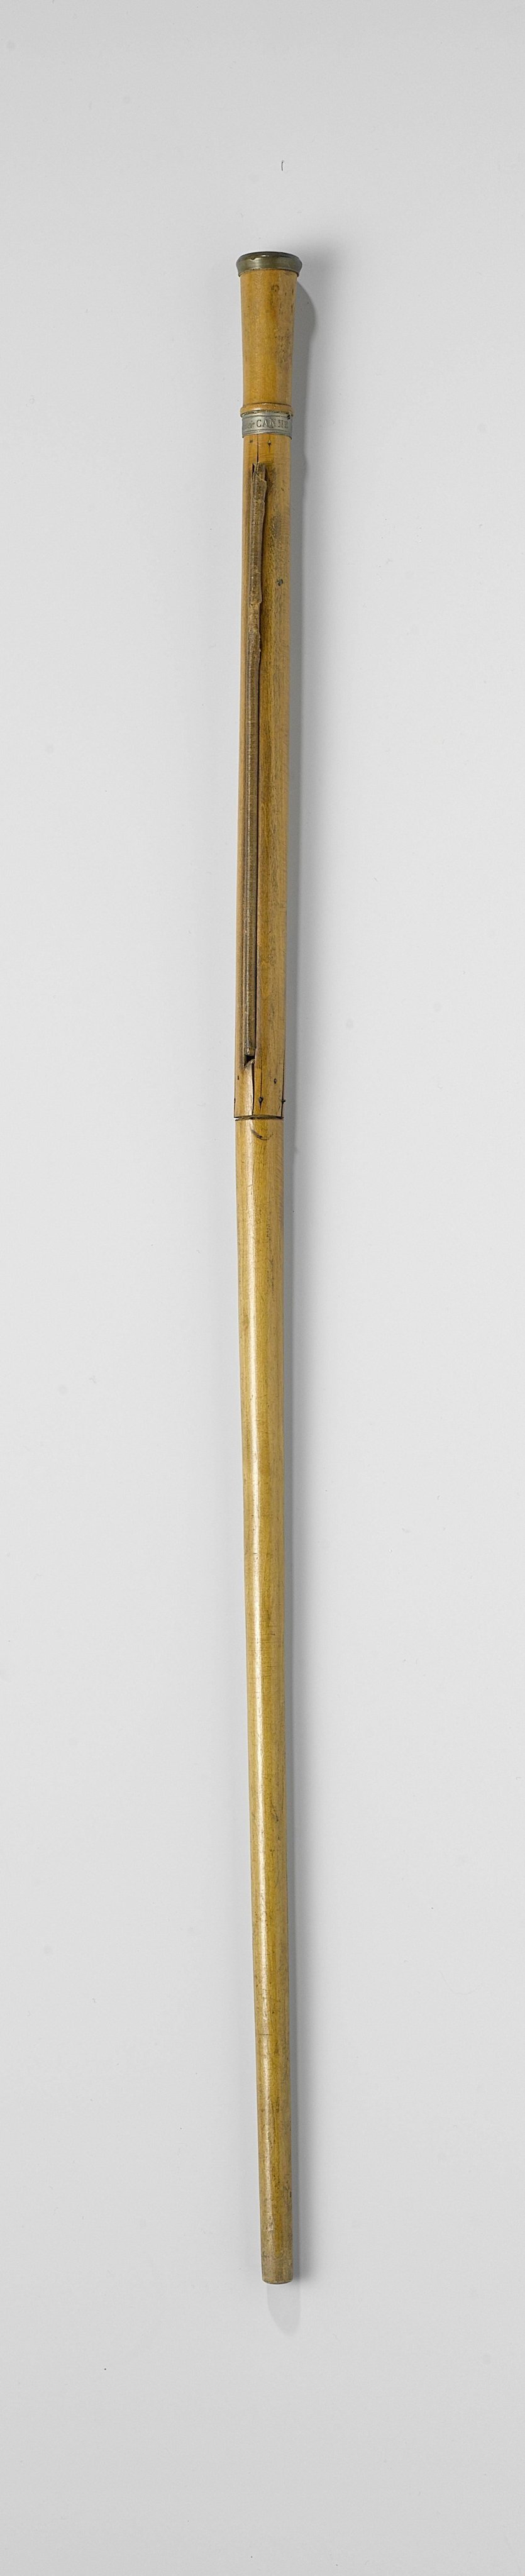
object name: walking stick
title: Wandelstok van gevernist hout met platte koperen knop, waarin opgerolde plattegrond Parijs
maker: g. dreyfus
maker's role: publisher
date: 1889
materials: copper, metal, paper, ink, wood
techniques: cutting, printing, striking, varnishing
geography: paris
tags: paris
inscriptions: name: ‘G. Dreyfus, 32 Rue de Paradis, Paris’, mark: ‘Déposée CANNE PLAN. G.D.’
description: Wandelstok van gevernist hout versierd met platte koperen knop en metalen rand, voorzien van opgerolde plattegrond. Model: recht en taps toelopend. Verdeeld in drie delen die d.m.v. een schuifverbinding en kopspijkers aan elkaar verbonden zijn. In het middelste deel een 26 cm lange verticale gleuf van 5 mm breed, waarin de stoffen plattegrond is opgerold. De metalen punt onder aan de stok ontbreekt. Versiering: in de gleuf wordt met een veer een bedrukt en geglansd stuk katoen opgerold dat aan beide zijden meerkleurige is bedrukt. Aan de ene kant is de plattegrond van de "Exposition Universelle de 1889" gedrukt en aan de andere kant die van de stad Parijs. Onderaan de kaarten het adres: G. Dreyfus, 32 Rue de Paradis, Paris. Merk: Déposée Canne Plan. G.D.